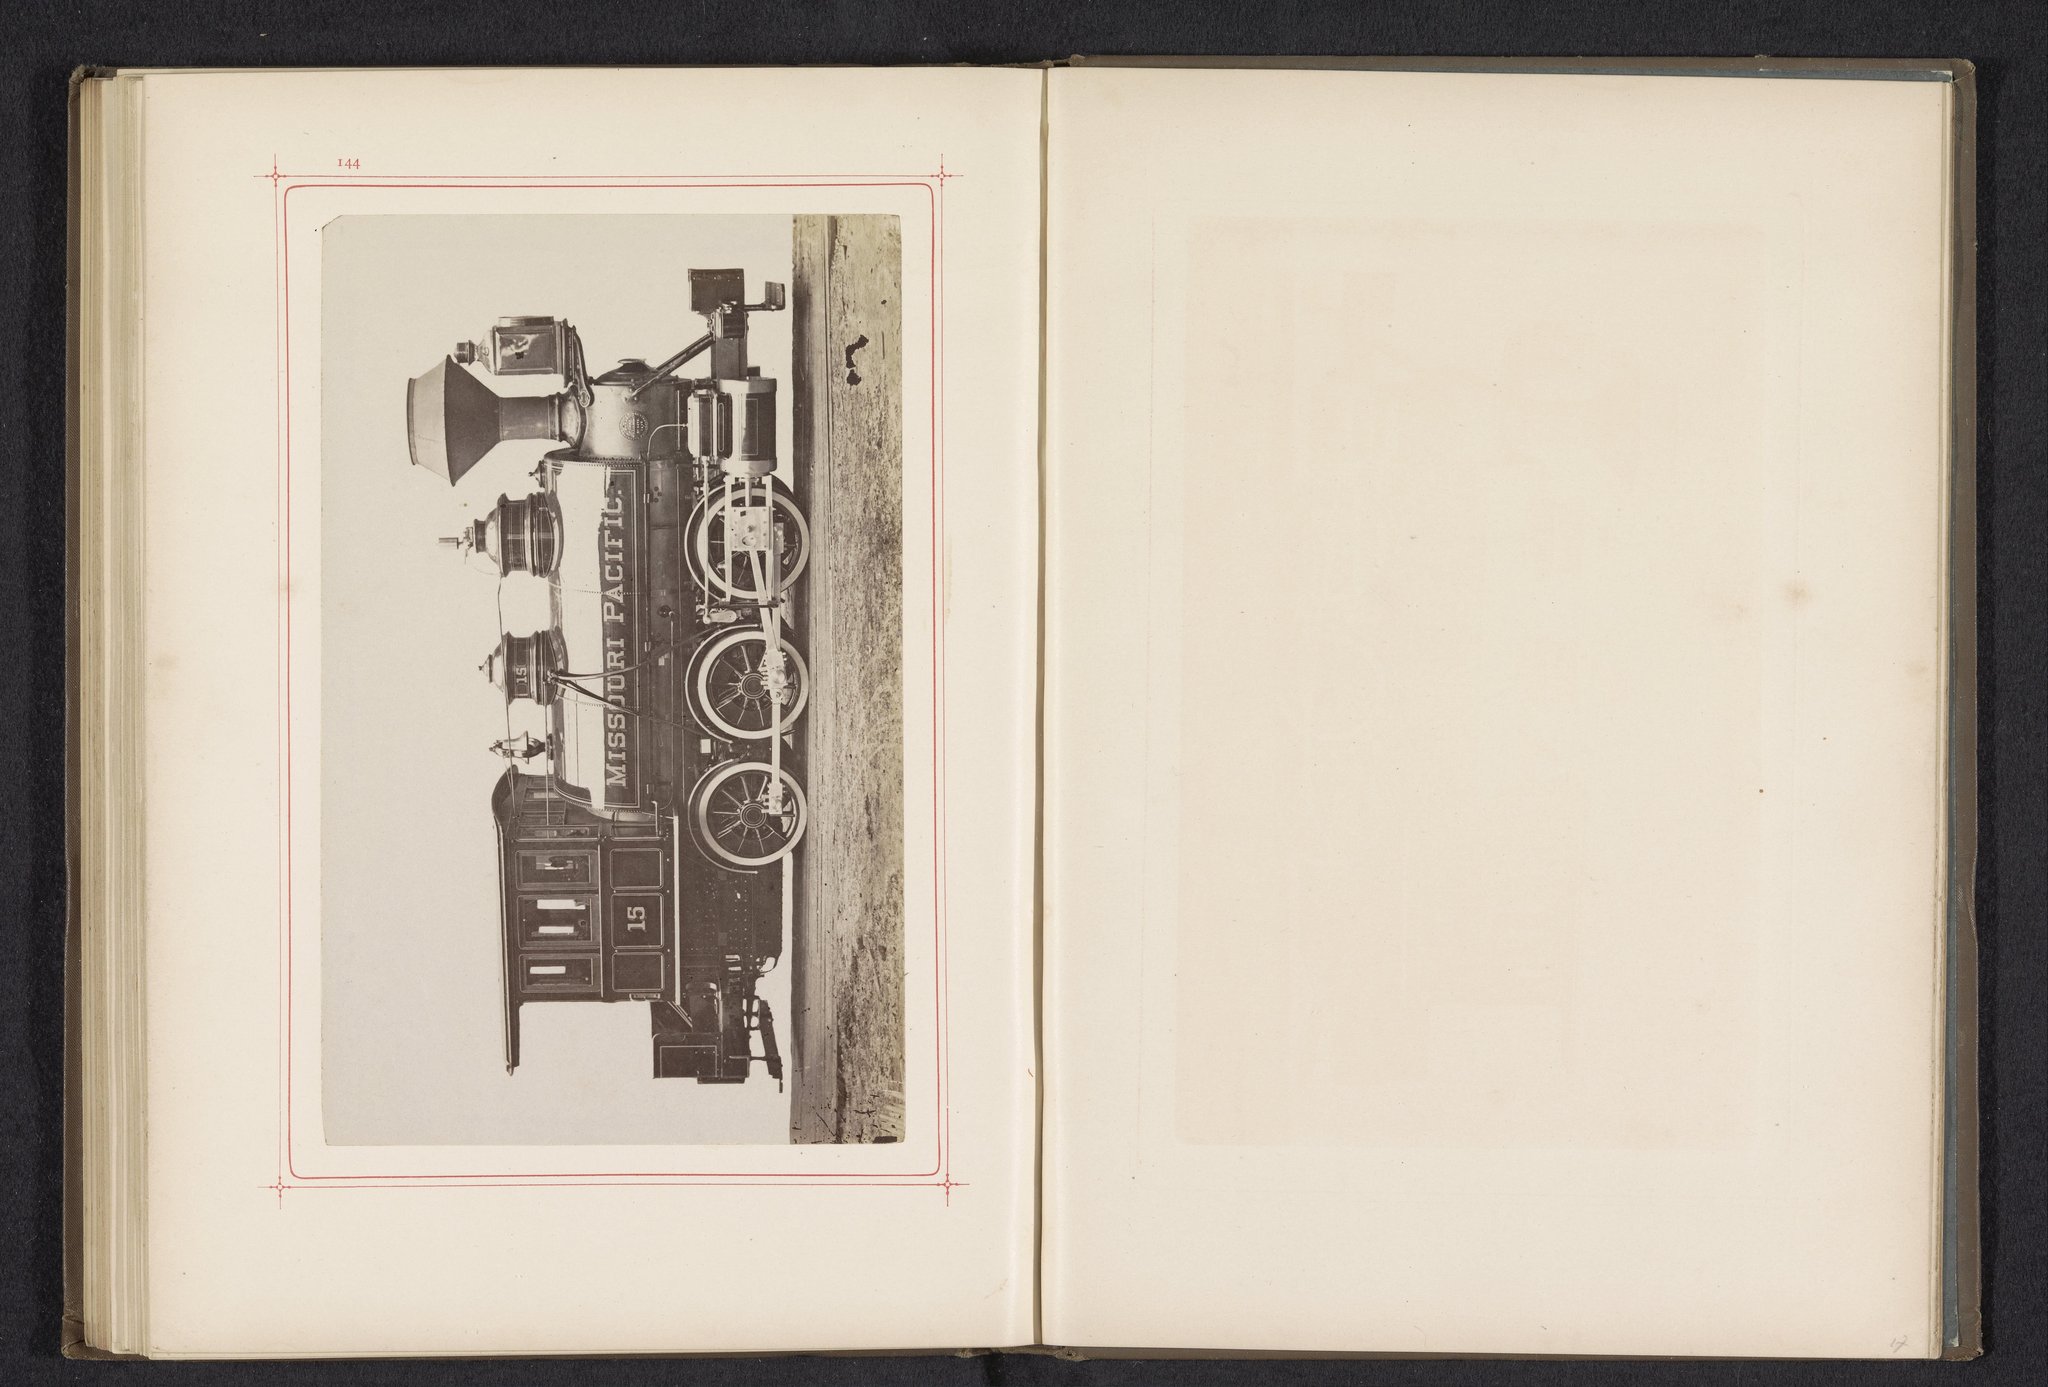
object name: photograph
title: Amerikaanse stoomlocomotief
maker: Anonymous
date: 1871-1881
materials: photographic support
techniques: albumen print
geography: united states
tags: steam locomotive